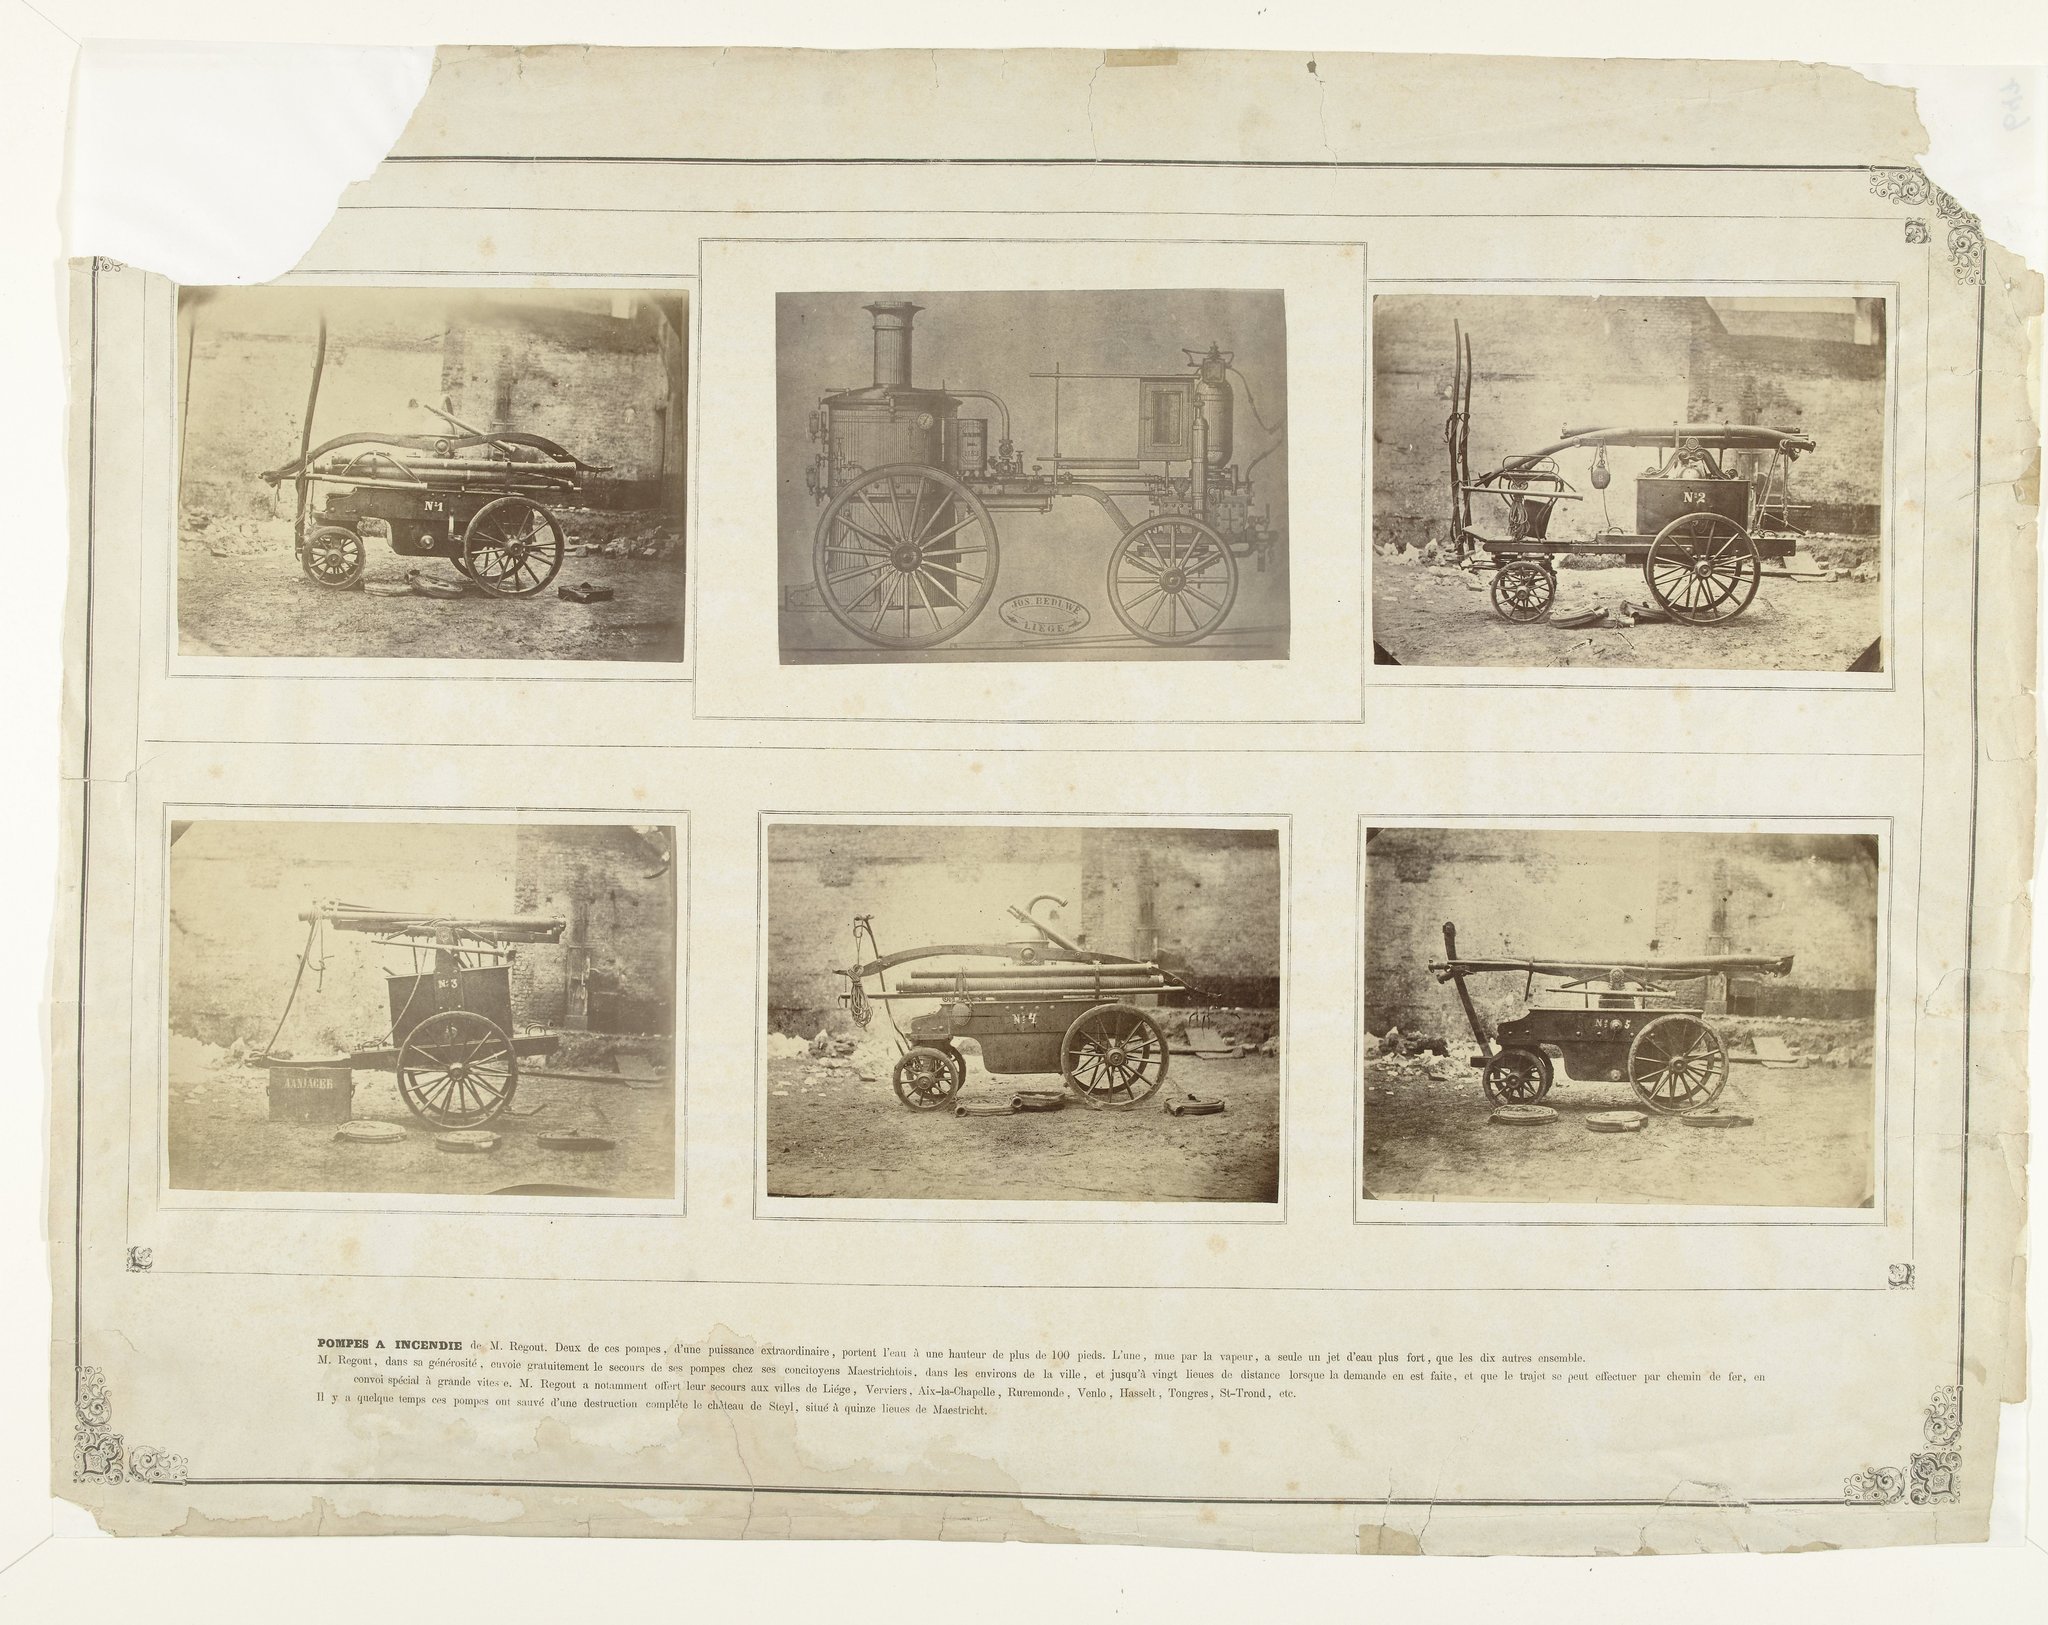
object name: photograph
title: Blad uit Album dedié à mes enfants et mes amis (1868) met opgeplakte foto's van brandspuiten van de firma's Regout en Beduwe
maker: Anonymous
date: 1868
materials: cardboard, photographic support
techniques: albumen print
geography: maastricht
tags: fire-extinguishing equipment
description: Brandspuit nummer 2 van de firma Regout op een blad met foto's van nog vijf andere brandspuiten afkomstig uit een album. Franse tekst onderaan het blad beschrijft de brandspuiten en de voordelen van het gebruik.